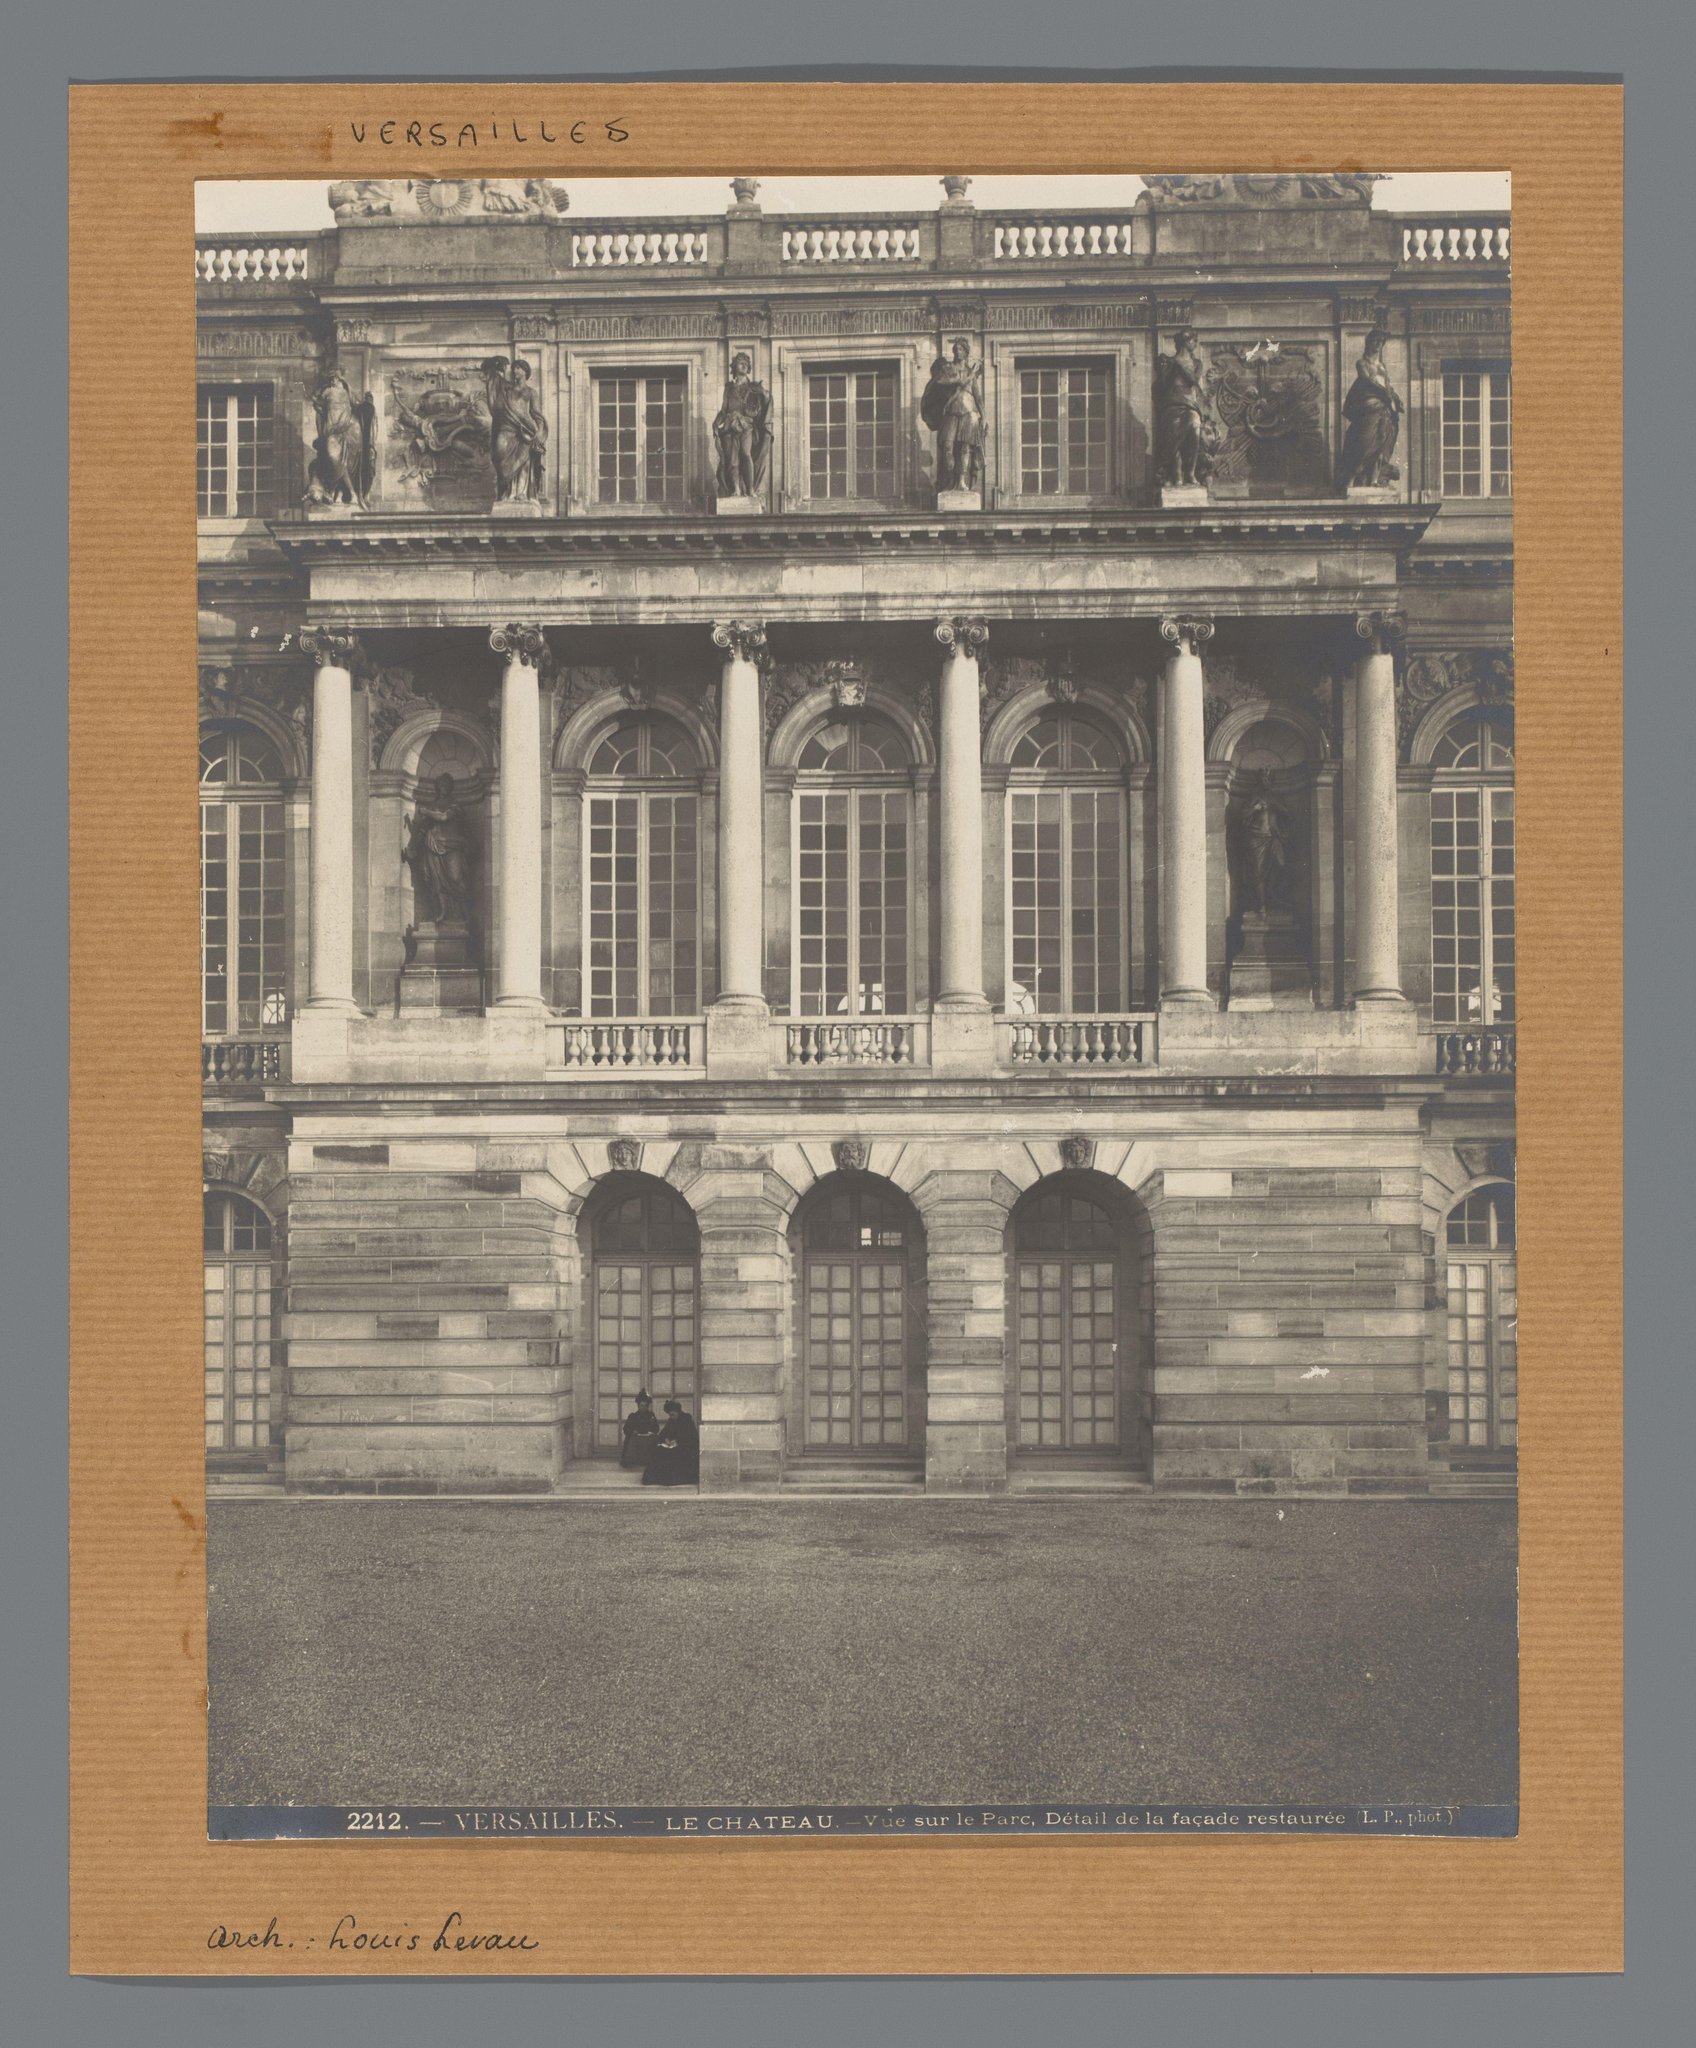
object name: photograph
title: Versailles. Palais der Koningen van Frankrijk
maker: Anonymous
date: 1880-1930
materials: photographic support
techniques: gelatin silver print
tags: kasteel van versailles